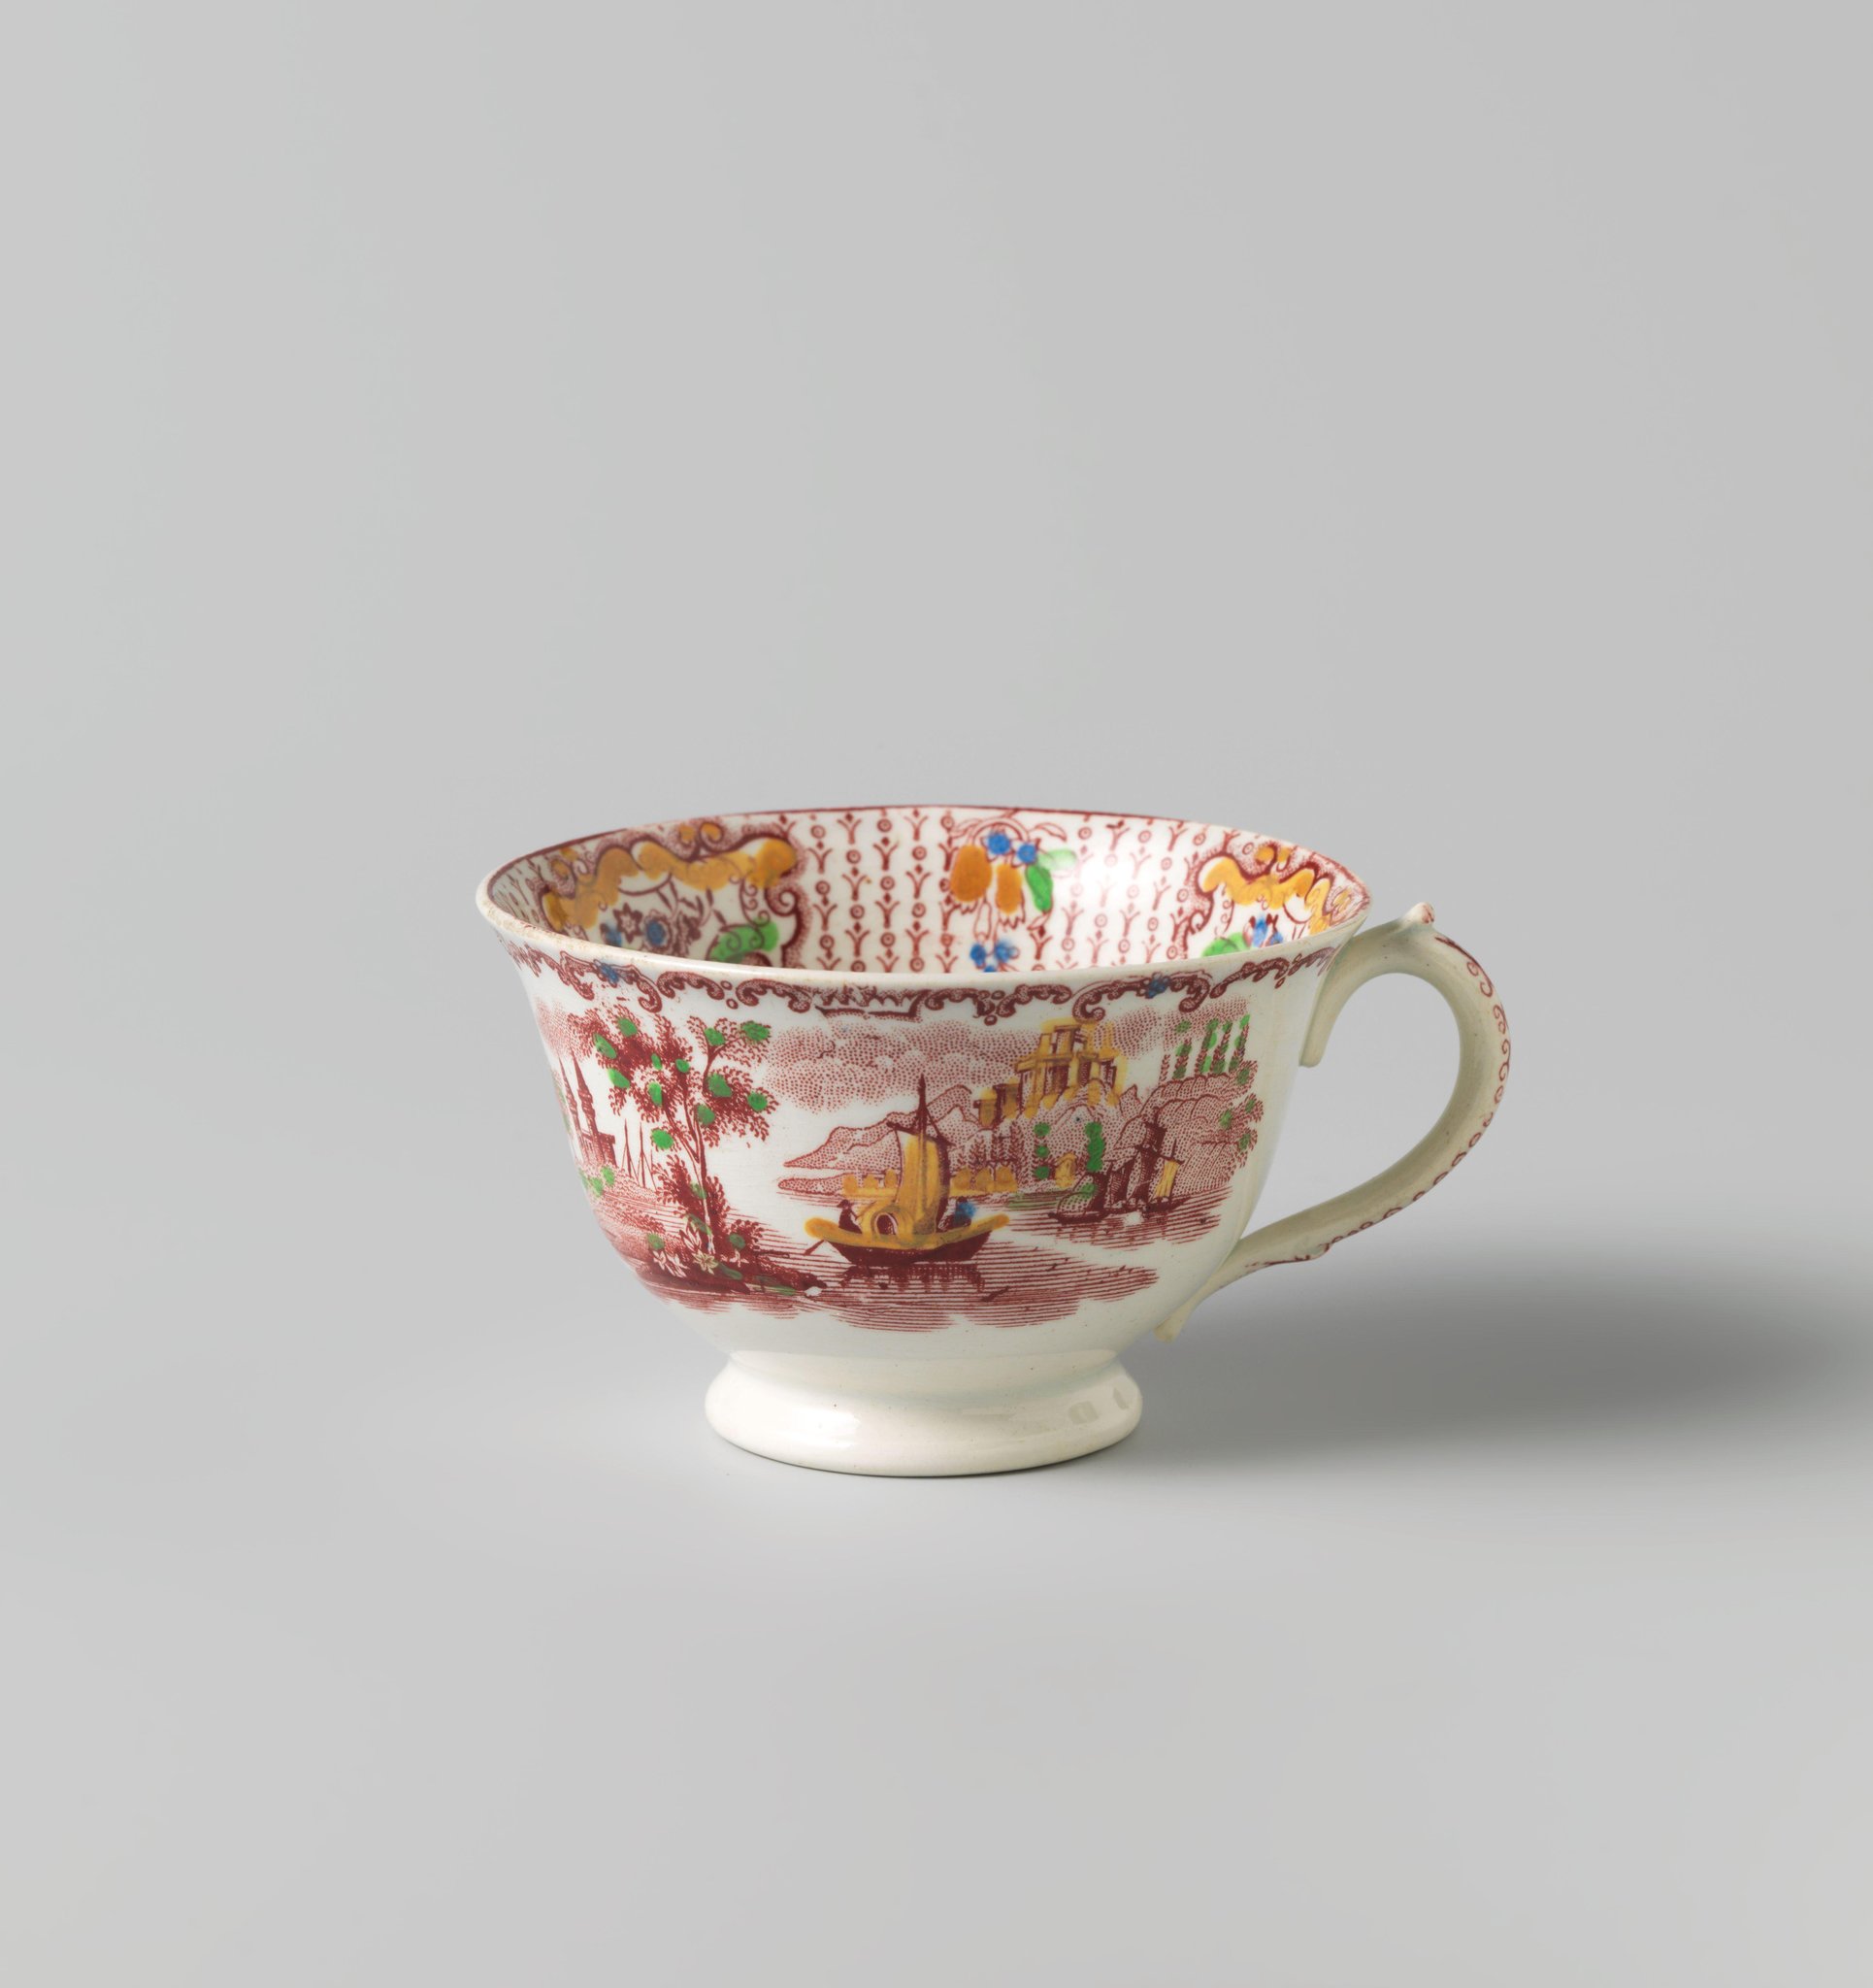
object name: cup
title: Kop met oor, met rivierlandschap met boten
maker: petrus regout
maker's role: plateelbakker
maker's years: 1801-1879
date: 1860-1890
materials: creamware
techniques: muffling, transfer decoration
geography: maastricht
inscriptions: mark: ‘11 in rood; 1 in blauw’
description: Kop van aardewerk met rood transferdecor en moffelkleuren. De buitenzijde met rivierlandschap met boten. Langs de mondrand c-voluten en bladwerk. De bodem toont een rivierlandschap met boot, de wand is aan de binnenzijde gedecoreerd met drie cartouches gevuld met bloemen. Tussen de cartouches drie boeketten en abstracte motieven. Het oor is versierd met krullen.